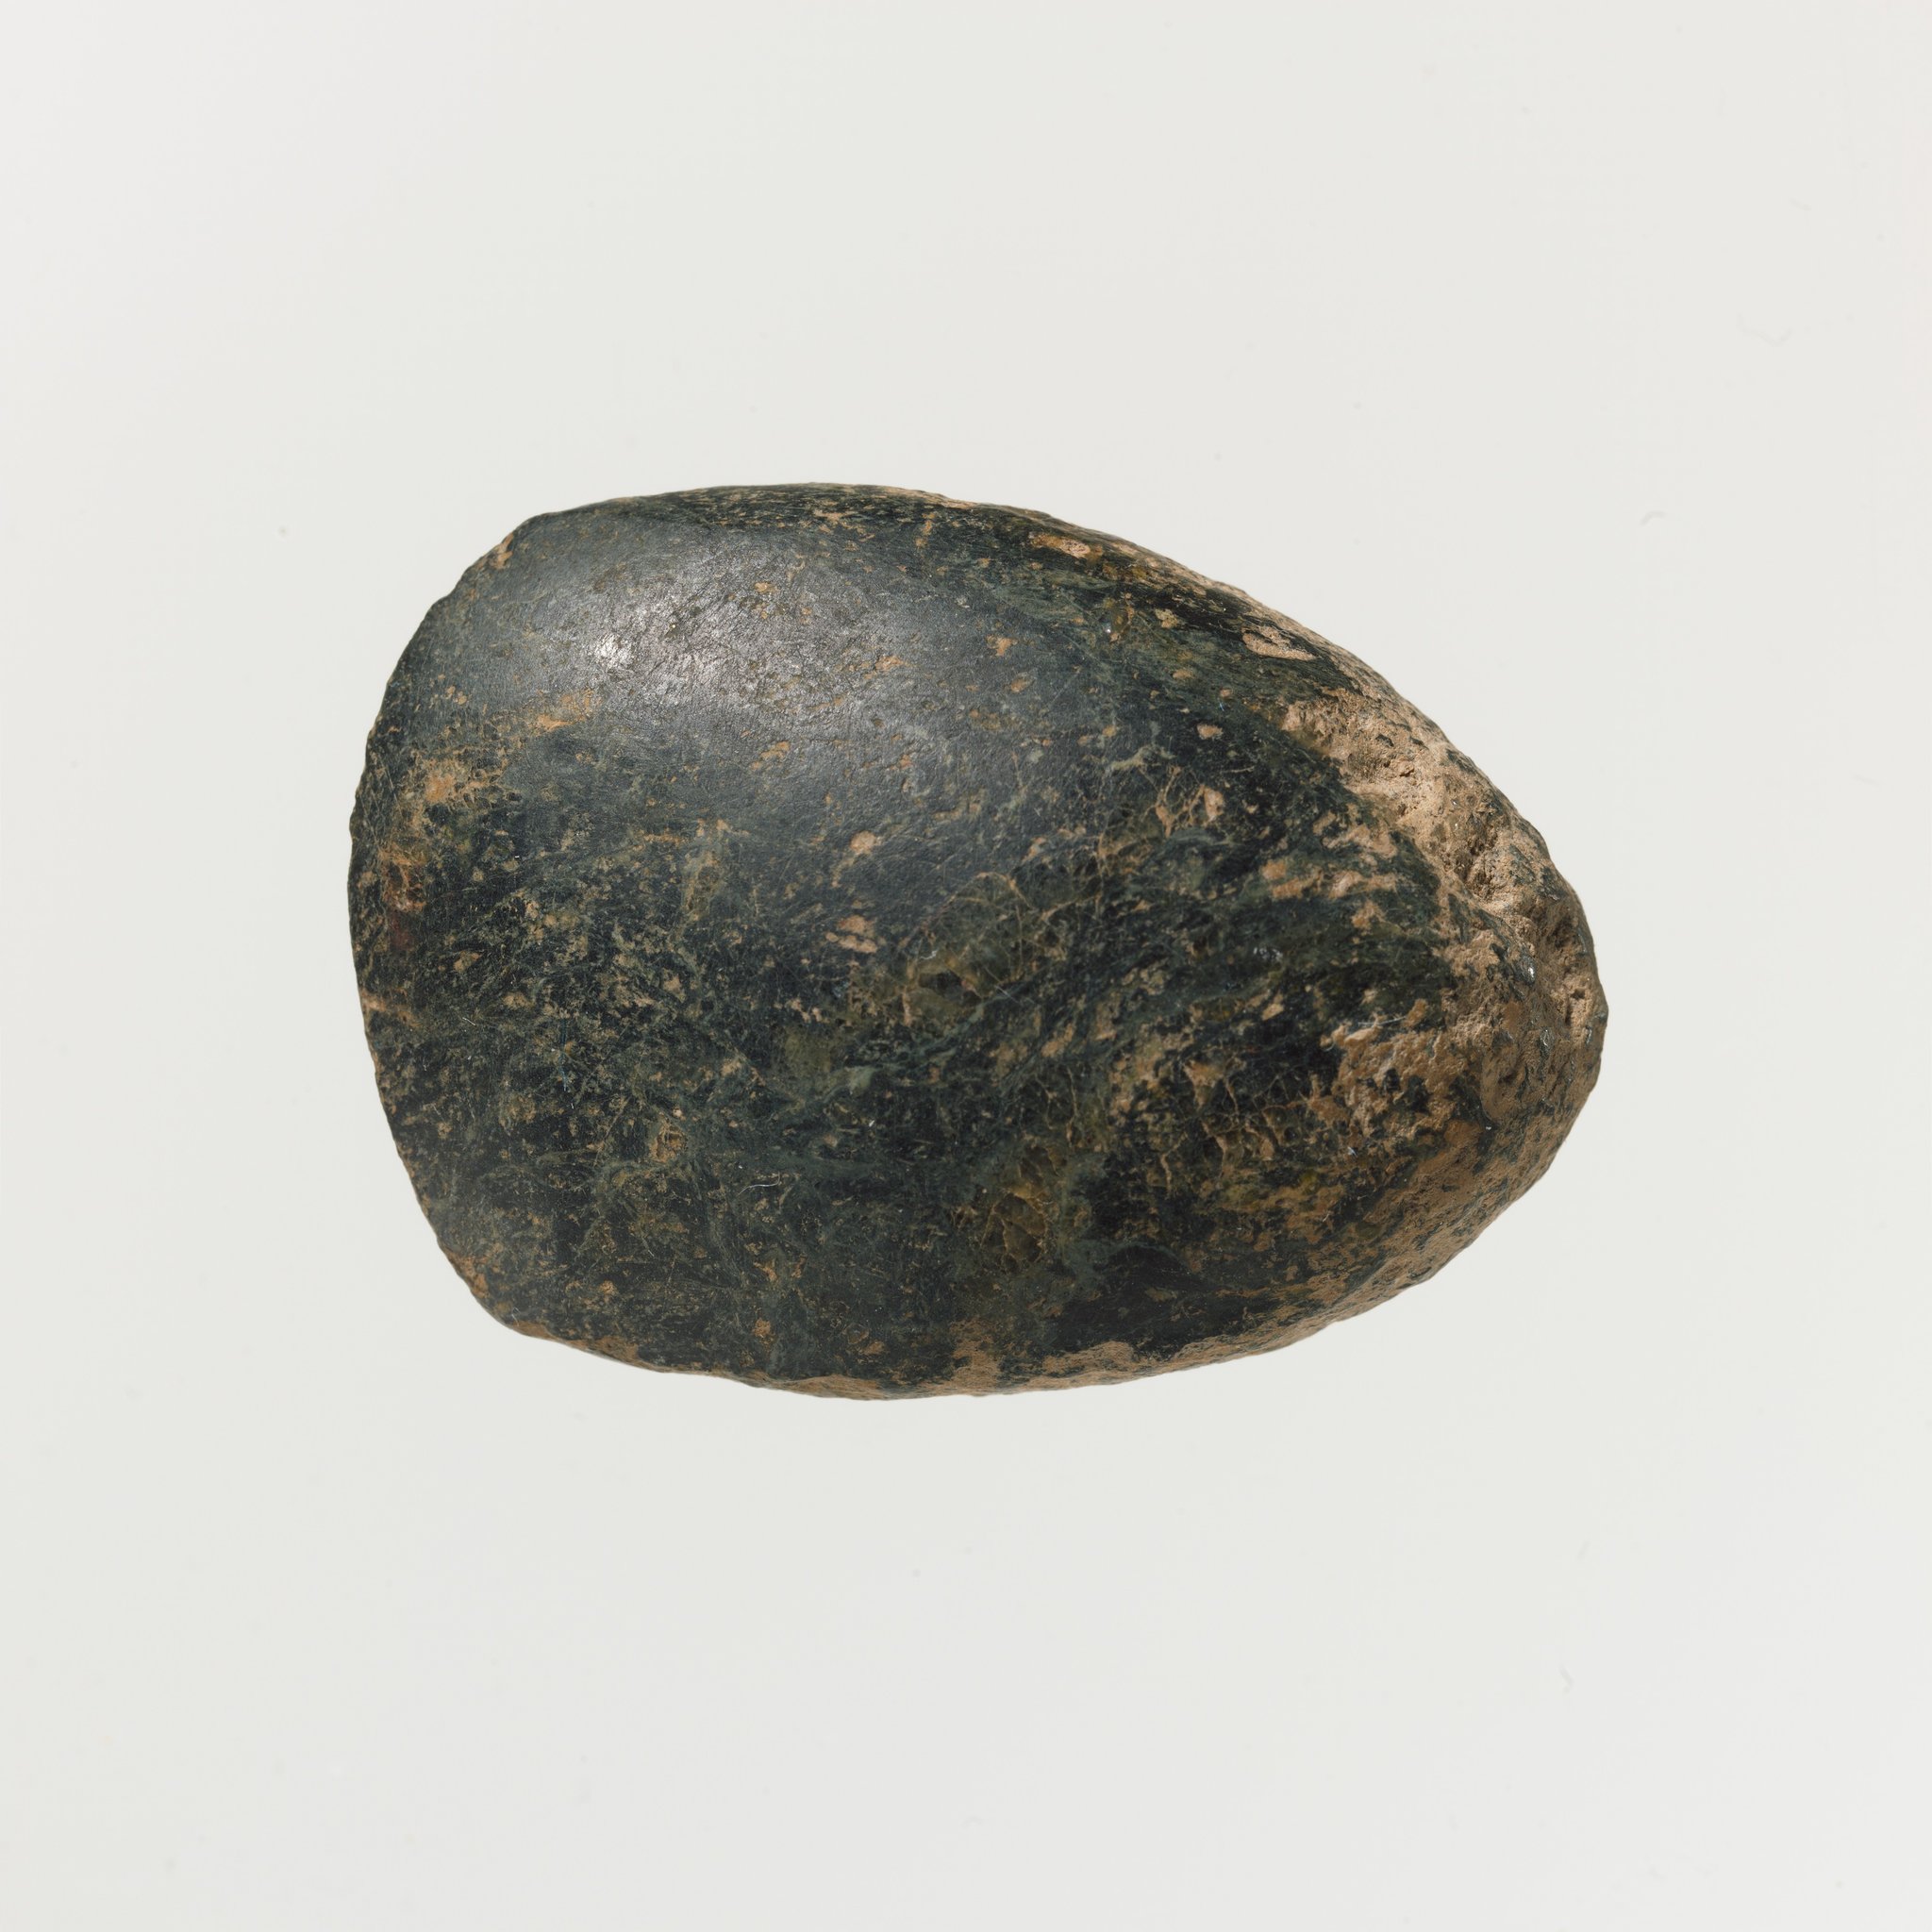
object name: celt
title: Small nephrite jade axe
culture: cretan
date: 5000-3001 BCE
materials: stone